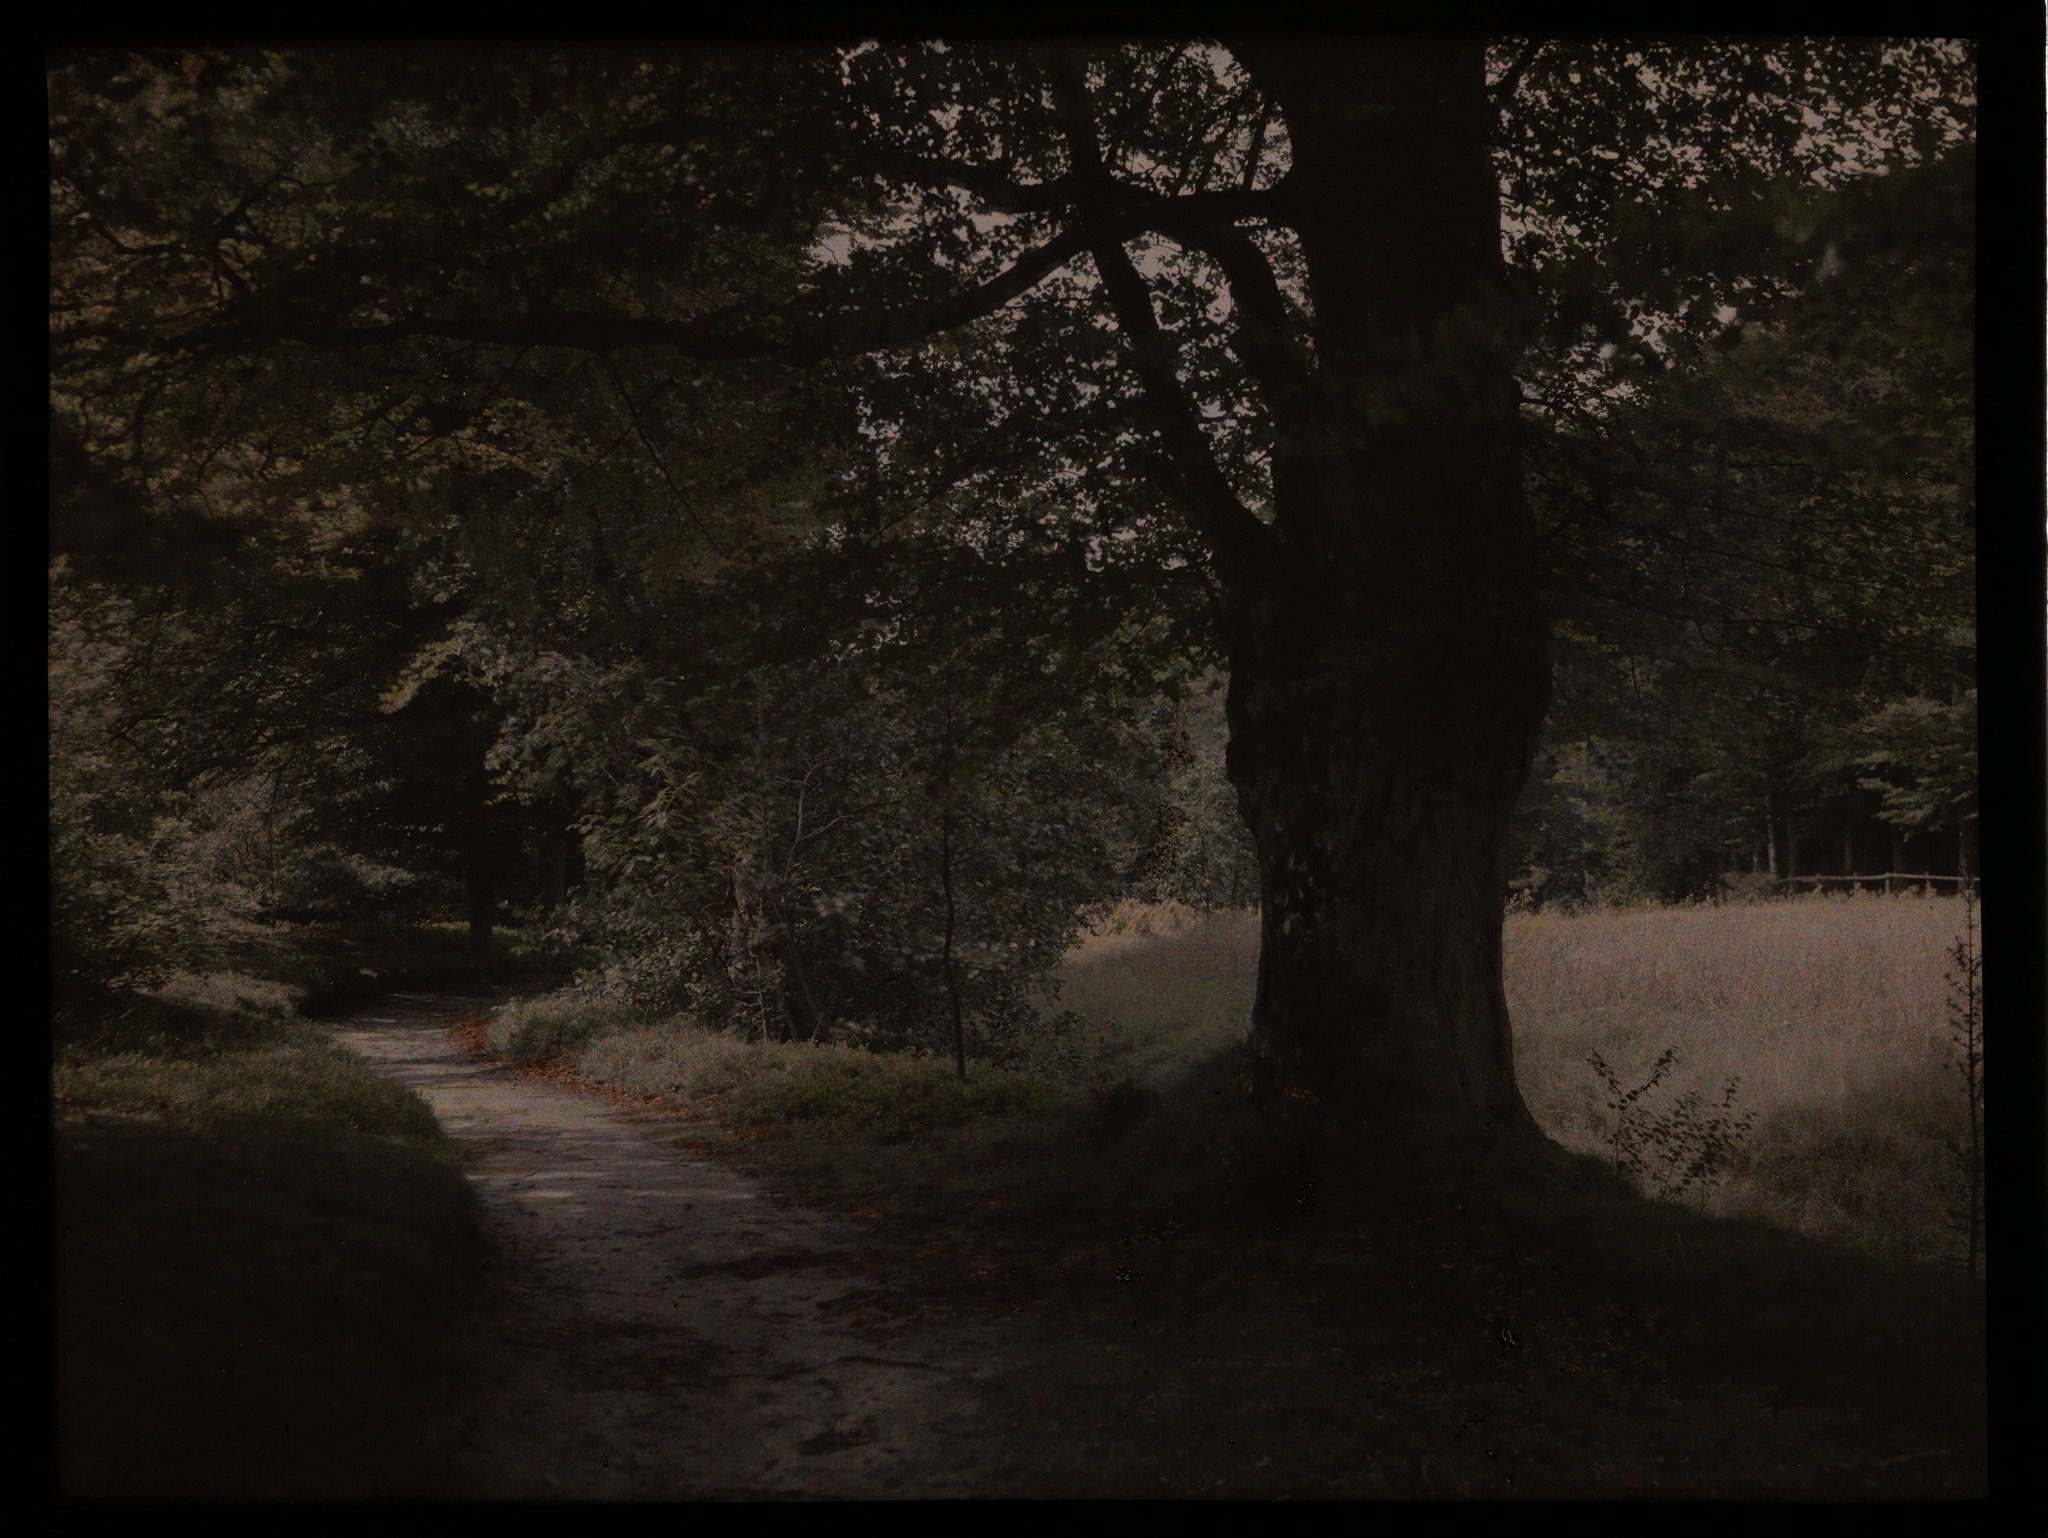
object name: photograph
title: Pad langs boom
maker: Anonymous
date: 1907-1935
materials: glass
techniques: autochrome process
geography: netherlands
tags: netherlands